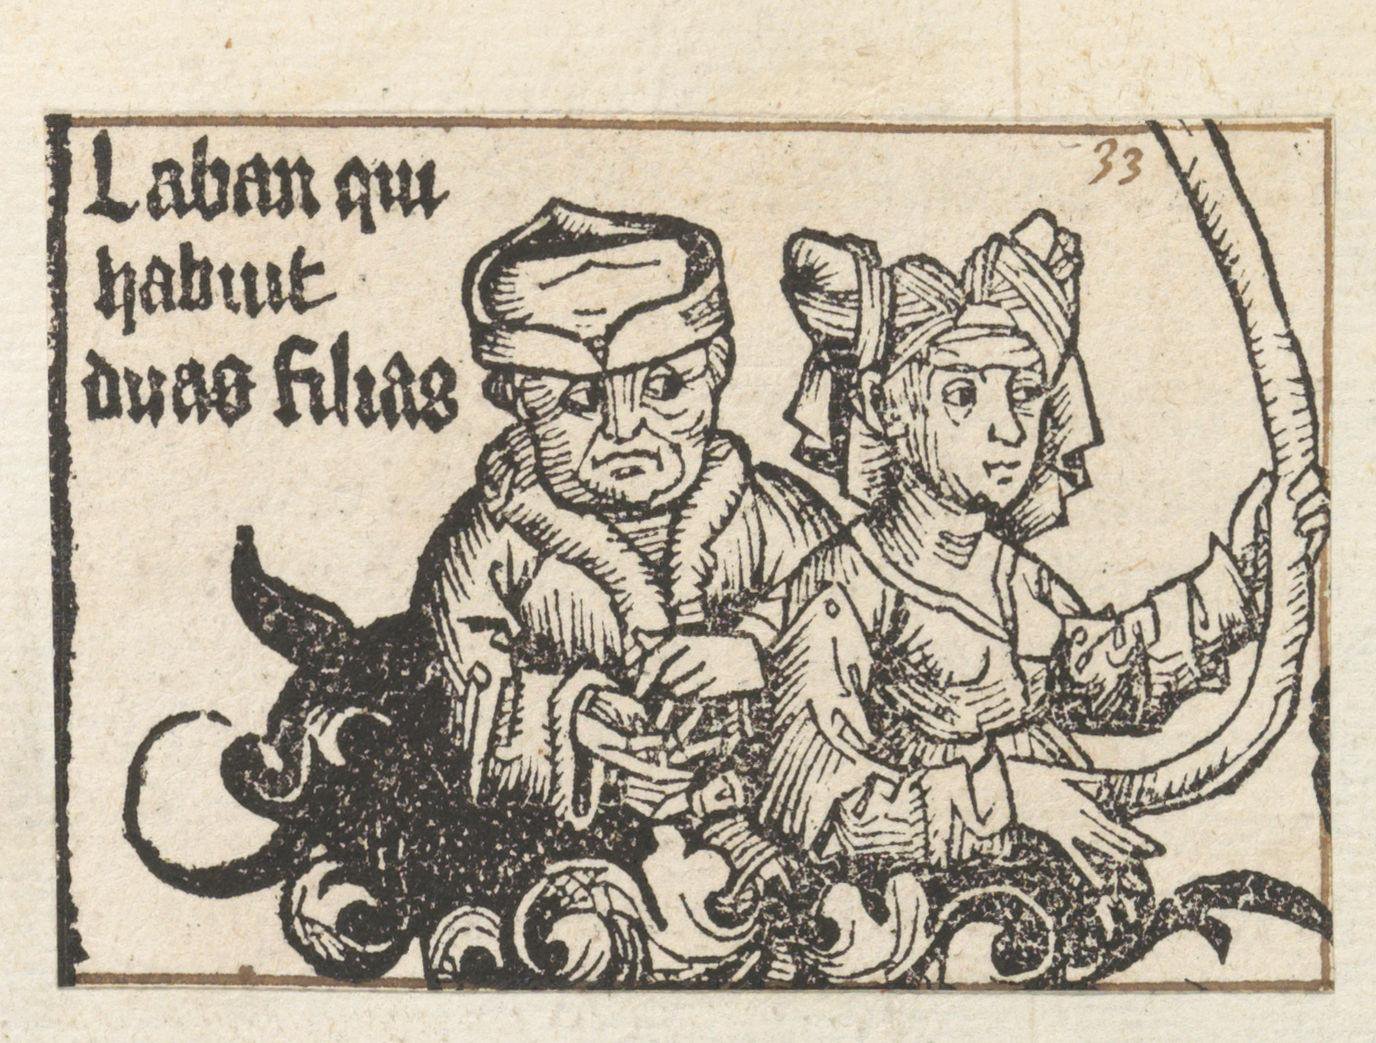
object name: album leaf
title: Laban en zijn vrouw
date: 1493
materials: paper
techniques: letterpress printing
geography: nuremberg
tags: persons from the old testament (not in biblical context, nor occurring in legendary/historical extensions included in division 71)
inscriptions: inscription: ‘34’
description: Een bloemkelk met een man en vrouw, geïdentificeerd als Laban en zijn vrouw. De voorstelling is een fragment van de stamboom van Christus in de Liber Chronicarum. De prent maakt deel uit van een album.